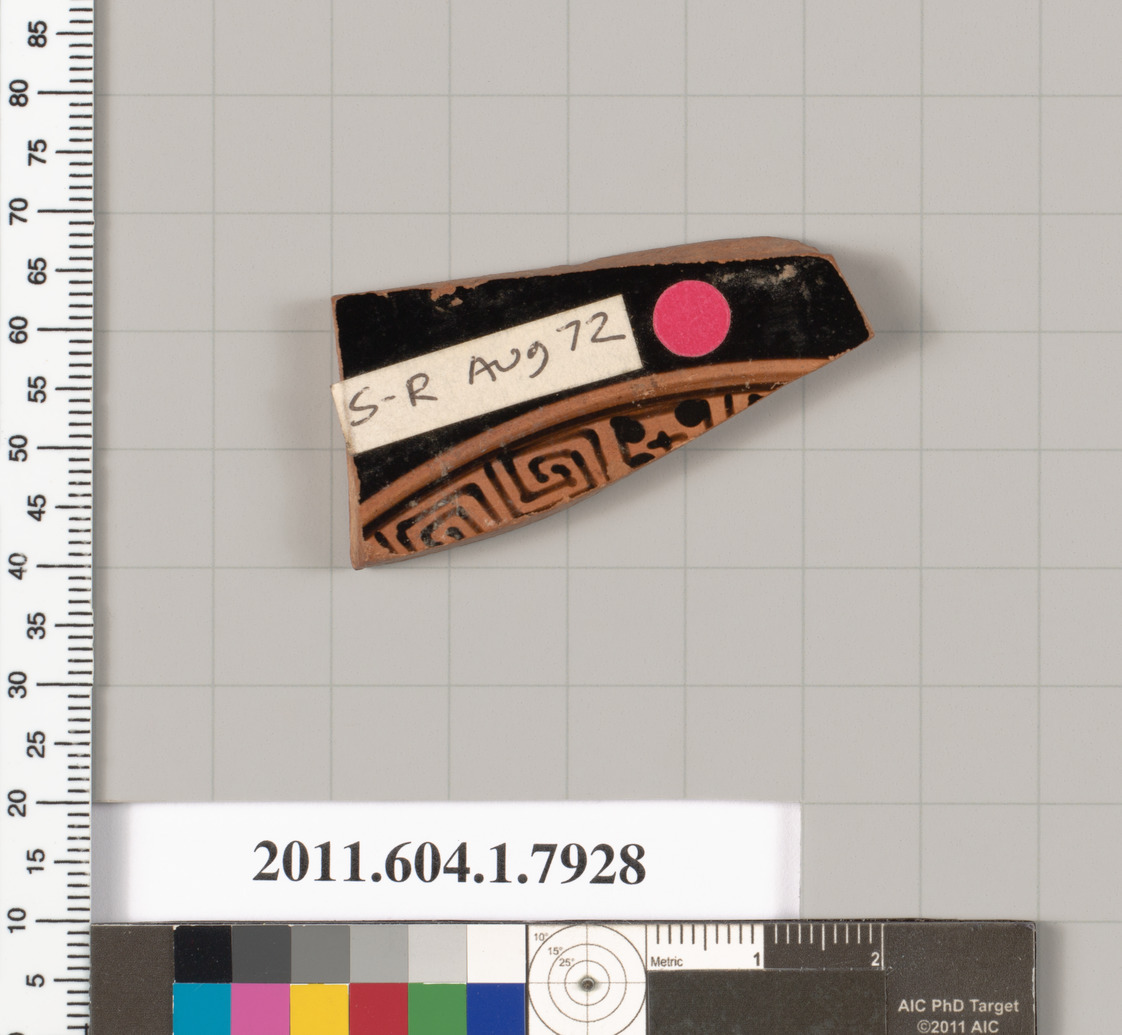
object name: kylix fragment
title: Terracotta fragment of a kylix (drinking cup)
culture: greek, attic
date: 460-450 BCE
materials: terracotta